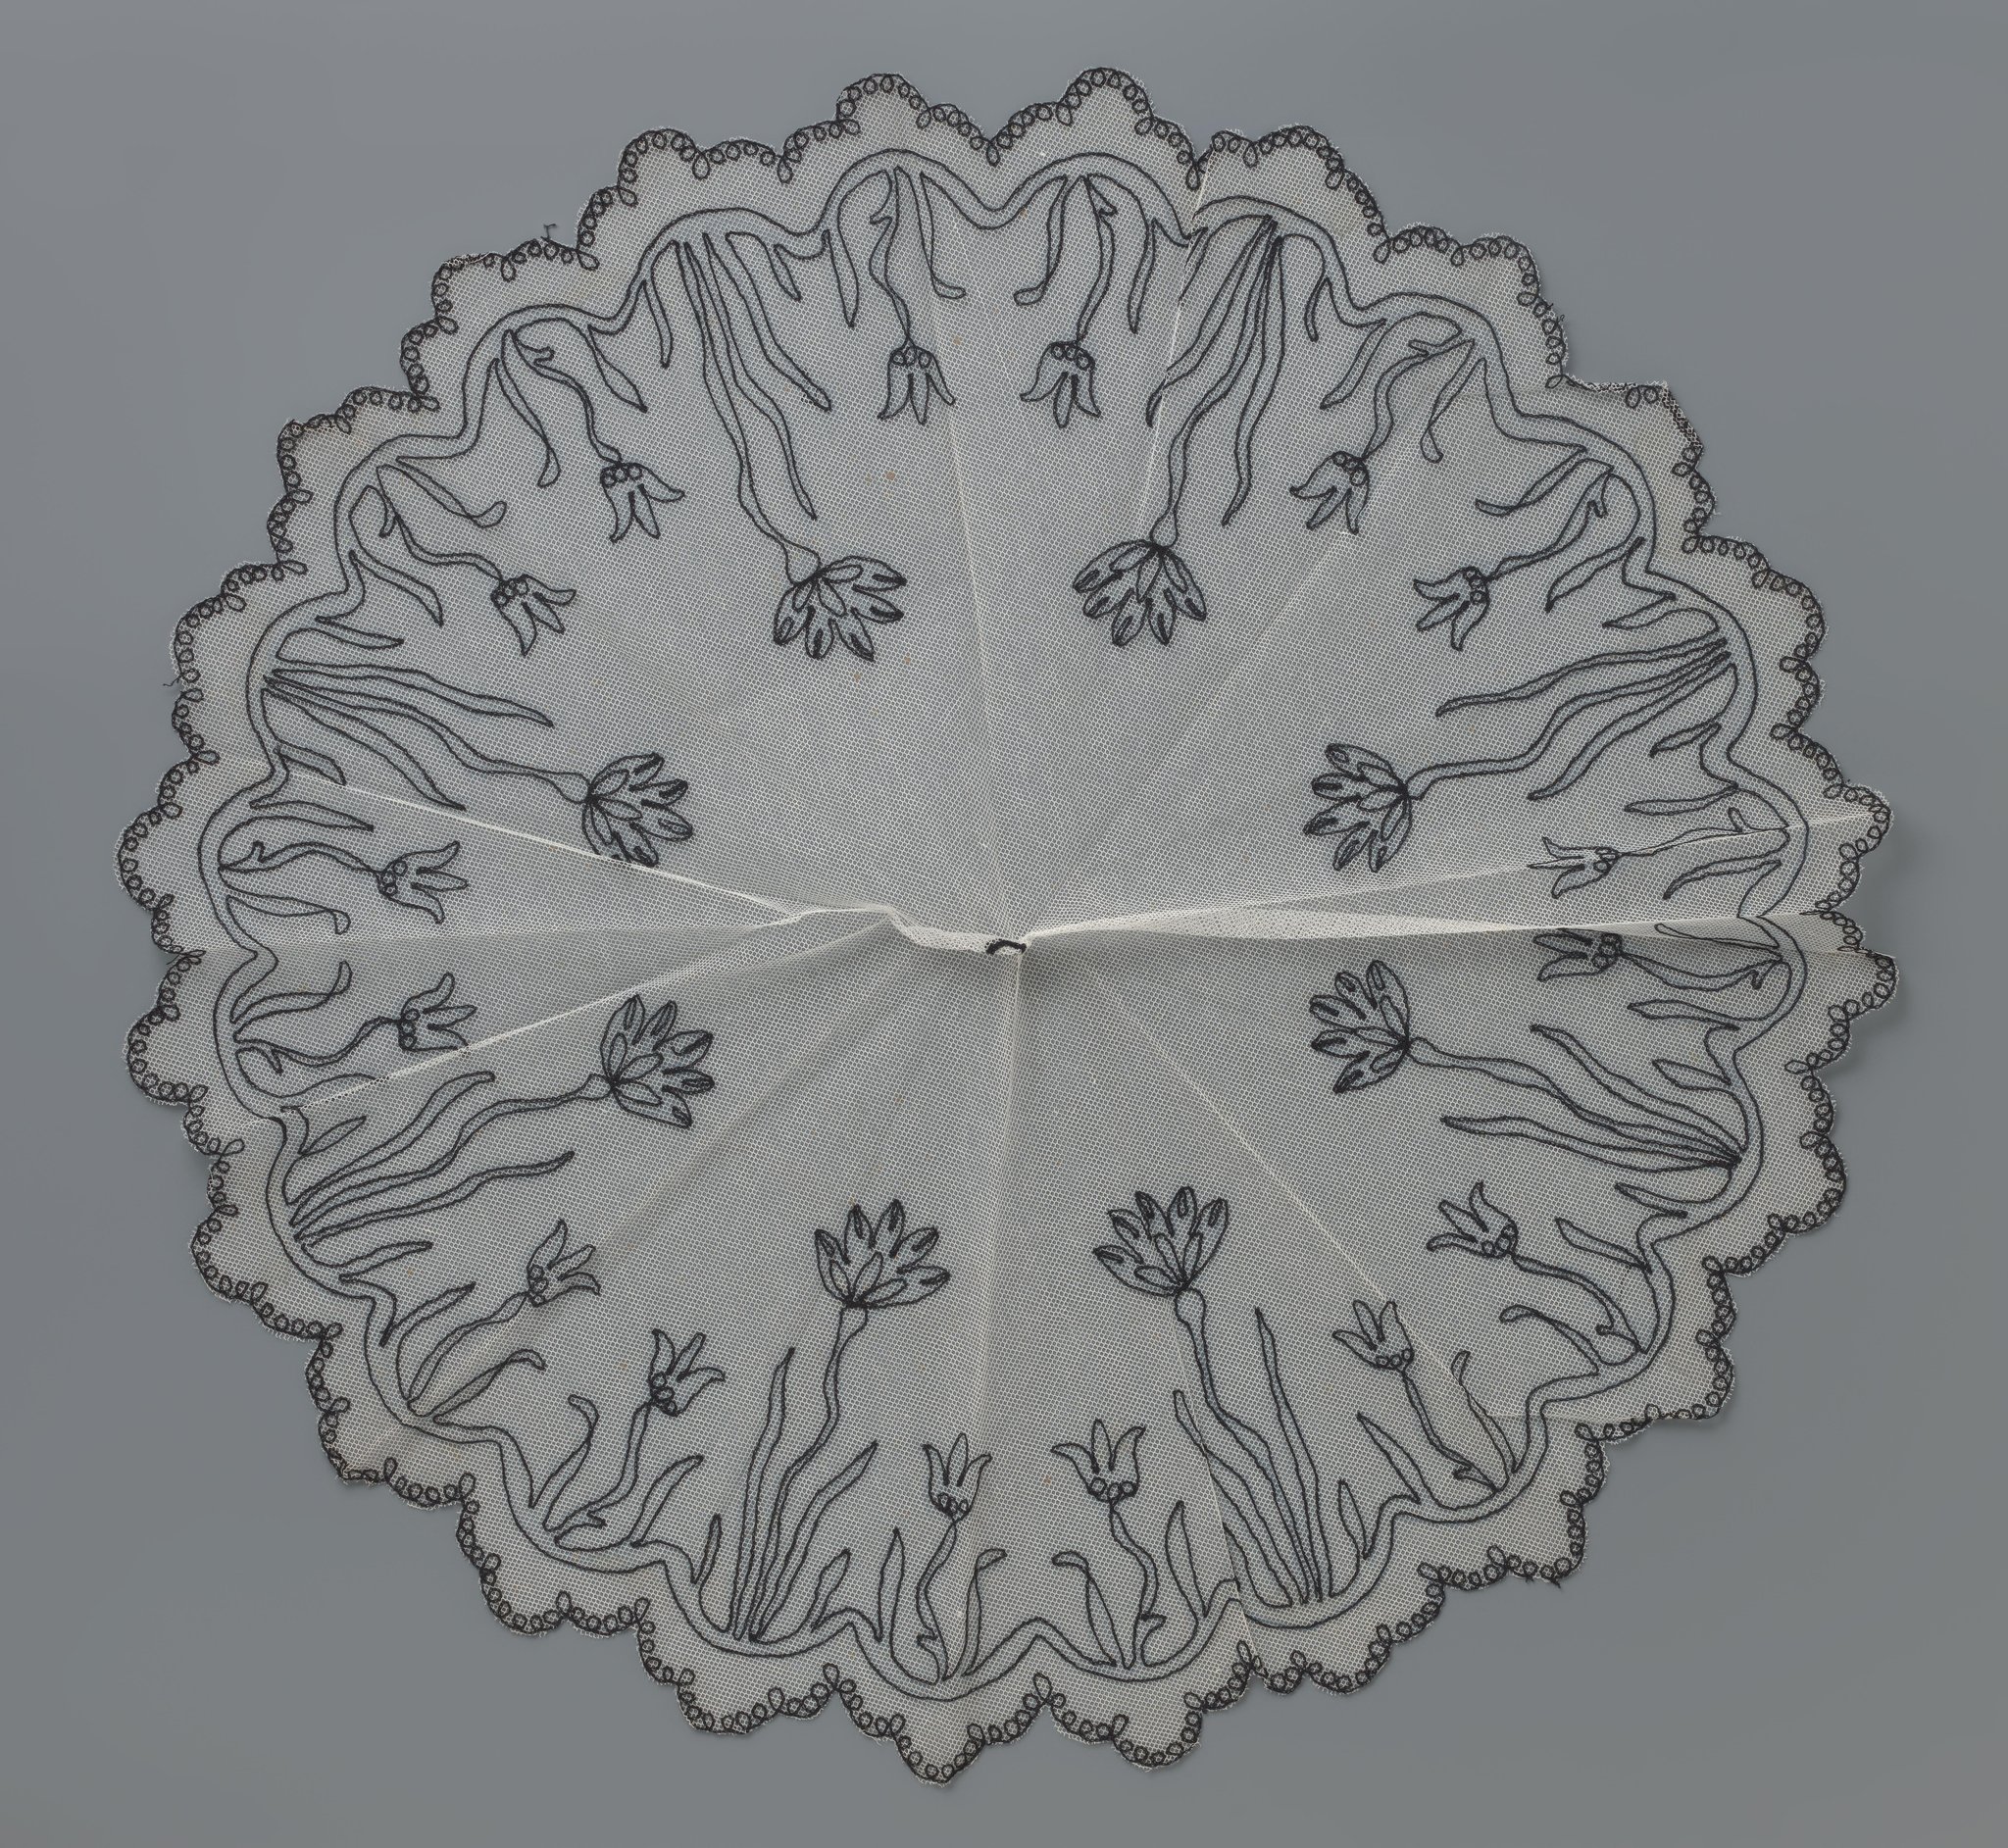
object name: womenswear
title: Parasoldek van witte tule, versierd met een tulpenpatroon in zwart tamboereerwerk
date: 1875-1900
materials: cotton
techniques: weave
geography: nijmegen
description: Parasoldek van witte tule; versierd met zwart tamboereerwerk. Het dek is rond en heeft een geschulpte rand. Langs de rand is het dek versierd met een tulpenpatroon uitgevoerd in zwart tamboereerwerk.